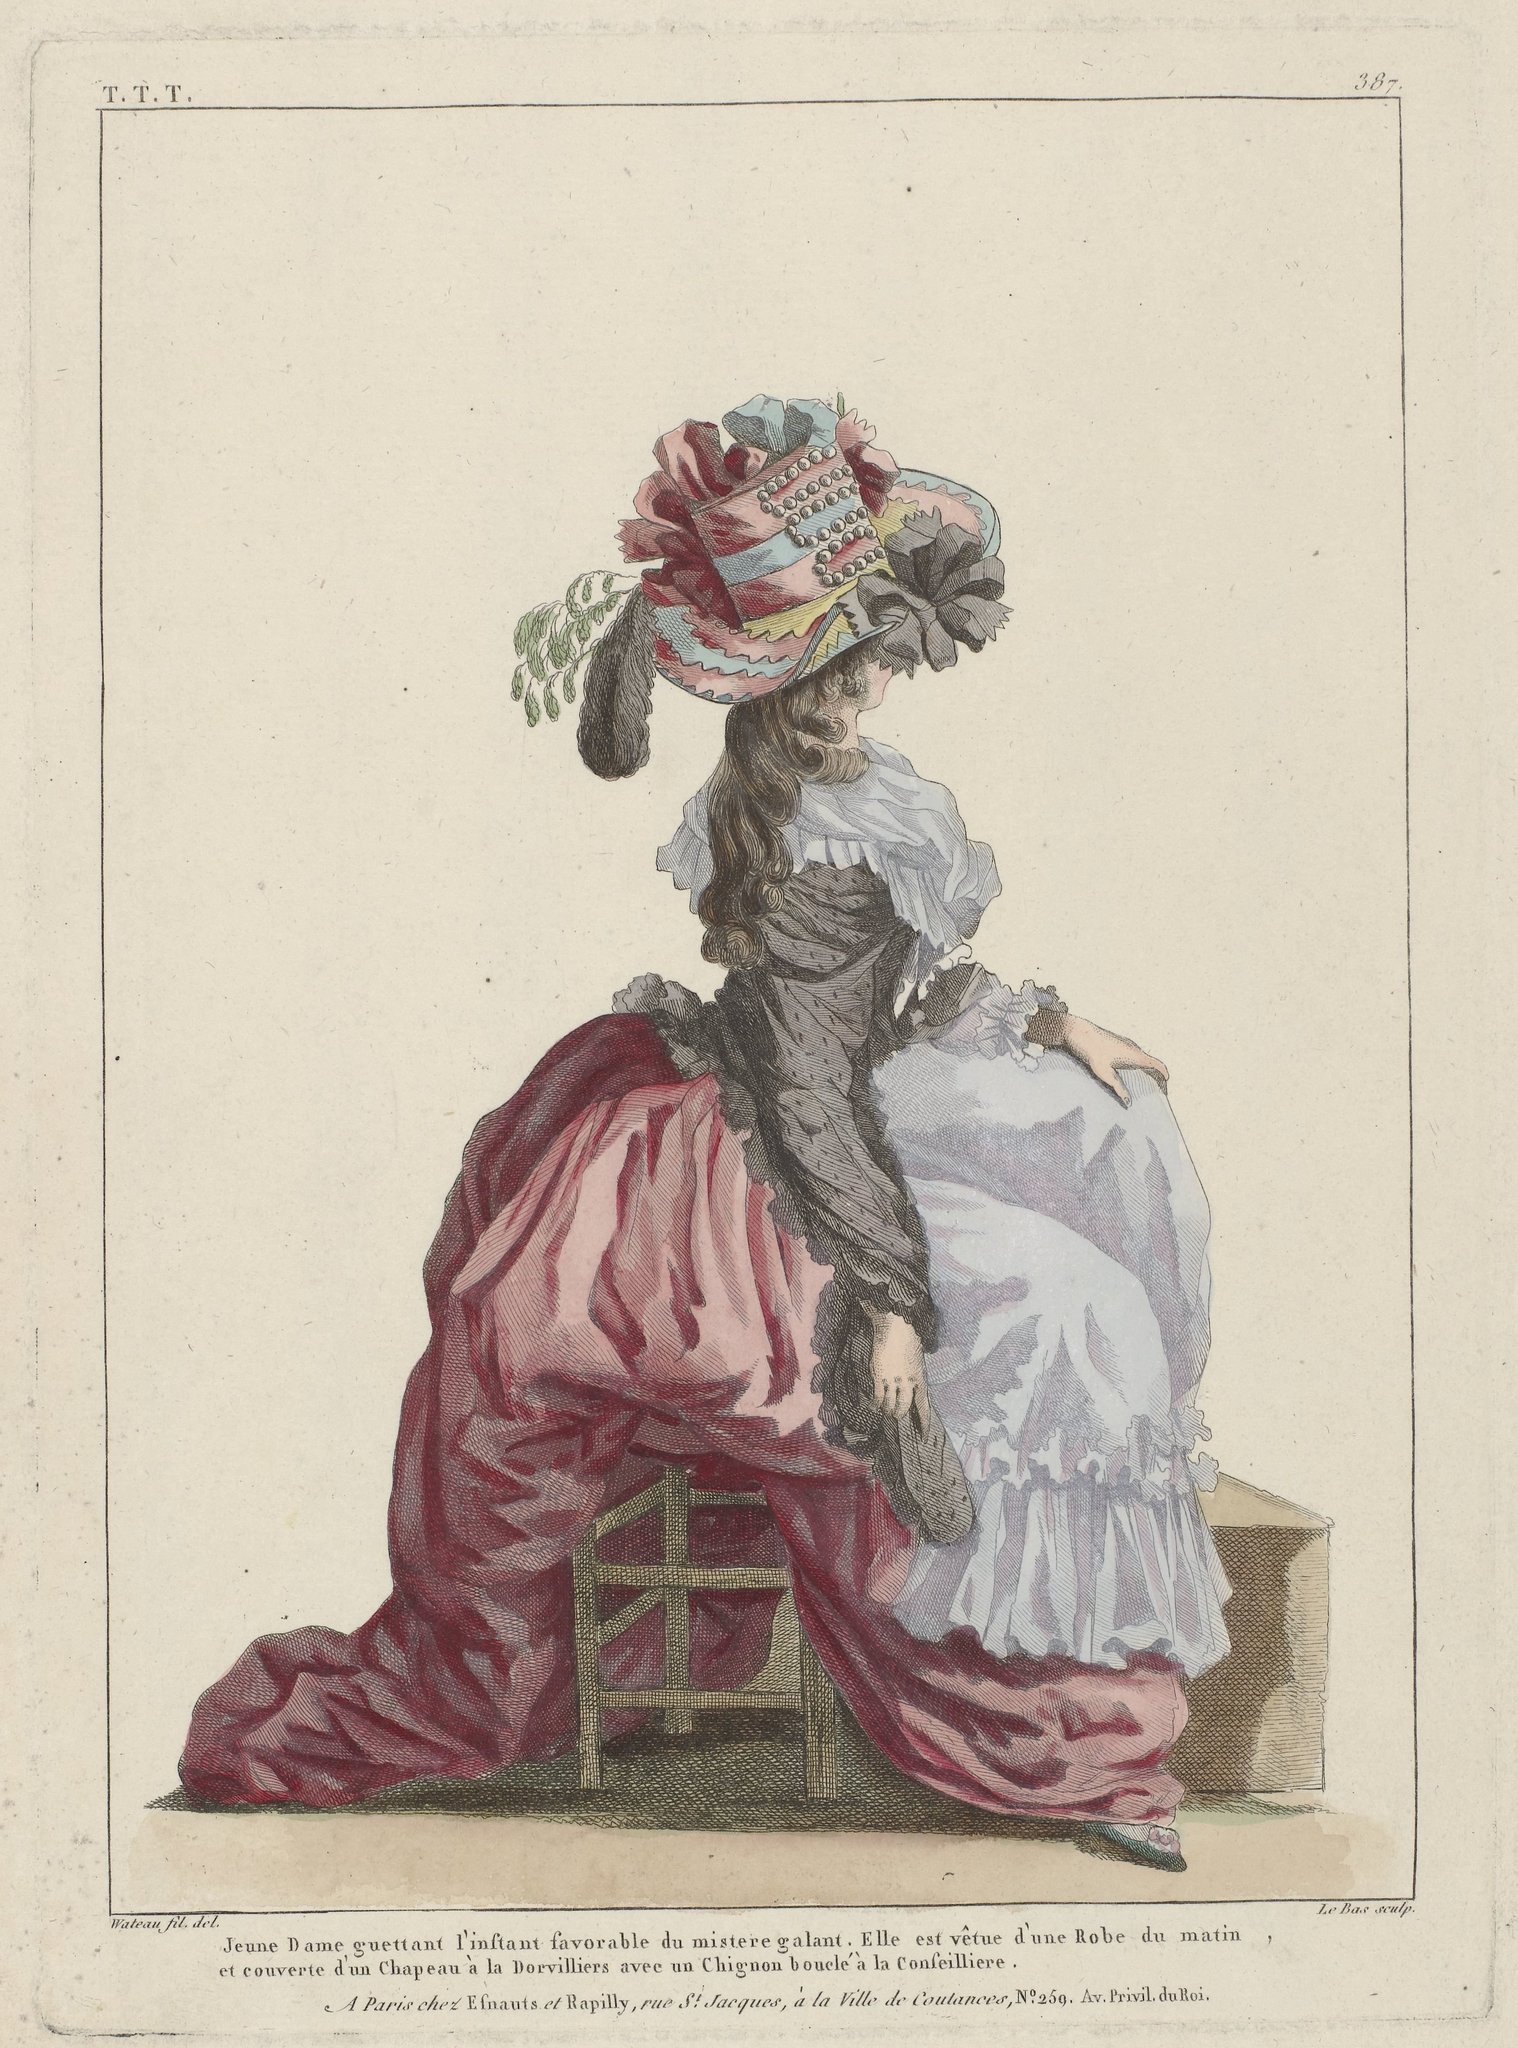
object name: fashion print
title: Gallerie des Modes et Costumes Français, 1787, TTT 387 : Jeune Dame guettant l'instant (...).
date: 1787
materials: paper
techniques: engraving, hand coloring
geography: paris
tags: clothing for the upper part of the body (+ women's clothes), dress, gown: morning dress (+ women's clothes), clothing for the upper part of the body (mantelet) (+ women's clothes), styles of hairdress - aa - ~ women, fashion plates, head-gear: hat (+ women's clothes), shoes, sandals (+ women's clothes), stool, apron (+ women's clothes), piece of clothing covering the breast or décolleté (fichu) (+ women's clothes)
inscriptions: caption: ‘Jeune Dame guettant l'instant favorable du mistere galant. Elle est vêtue d'une Robe du matin et couverte d'un Chapeau à la Dorvilliers avec un Chignon bouclé à la Conseilliere.’, address: ‘A Paris chez Esnauts et Rapilly, rue St. Jacques, à la Ville de Coutances, No. 259. Av. Privil. du Roi.’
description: Zittende jonge vrouw gekleed in een rode ochtendjapon. Over de japon een gestippelde kleine schoudermantel en een sierschort afgezet met een gerimpelde strook stof. Fichu. Kapsel met chignon en krullen 'à la Conseilliere', getooid met een 'Chapeau à la Dorvilliers'. Schoen met rozet. Uit serie TTT. 60e Cahier de Costumes Français, Habillemens à la mode, Gallerie des Modes et Costumes Français.